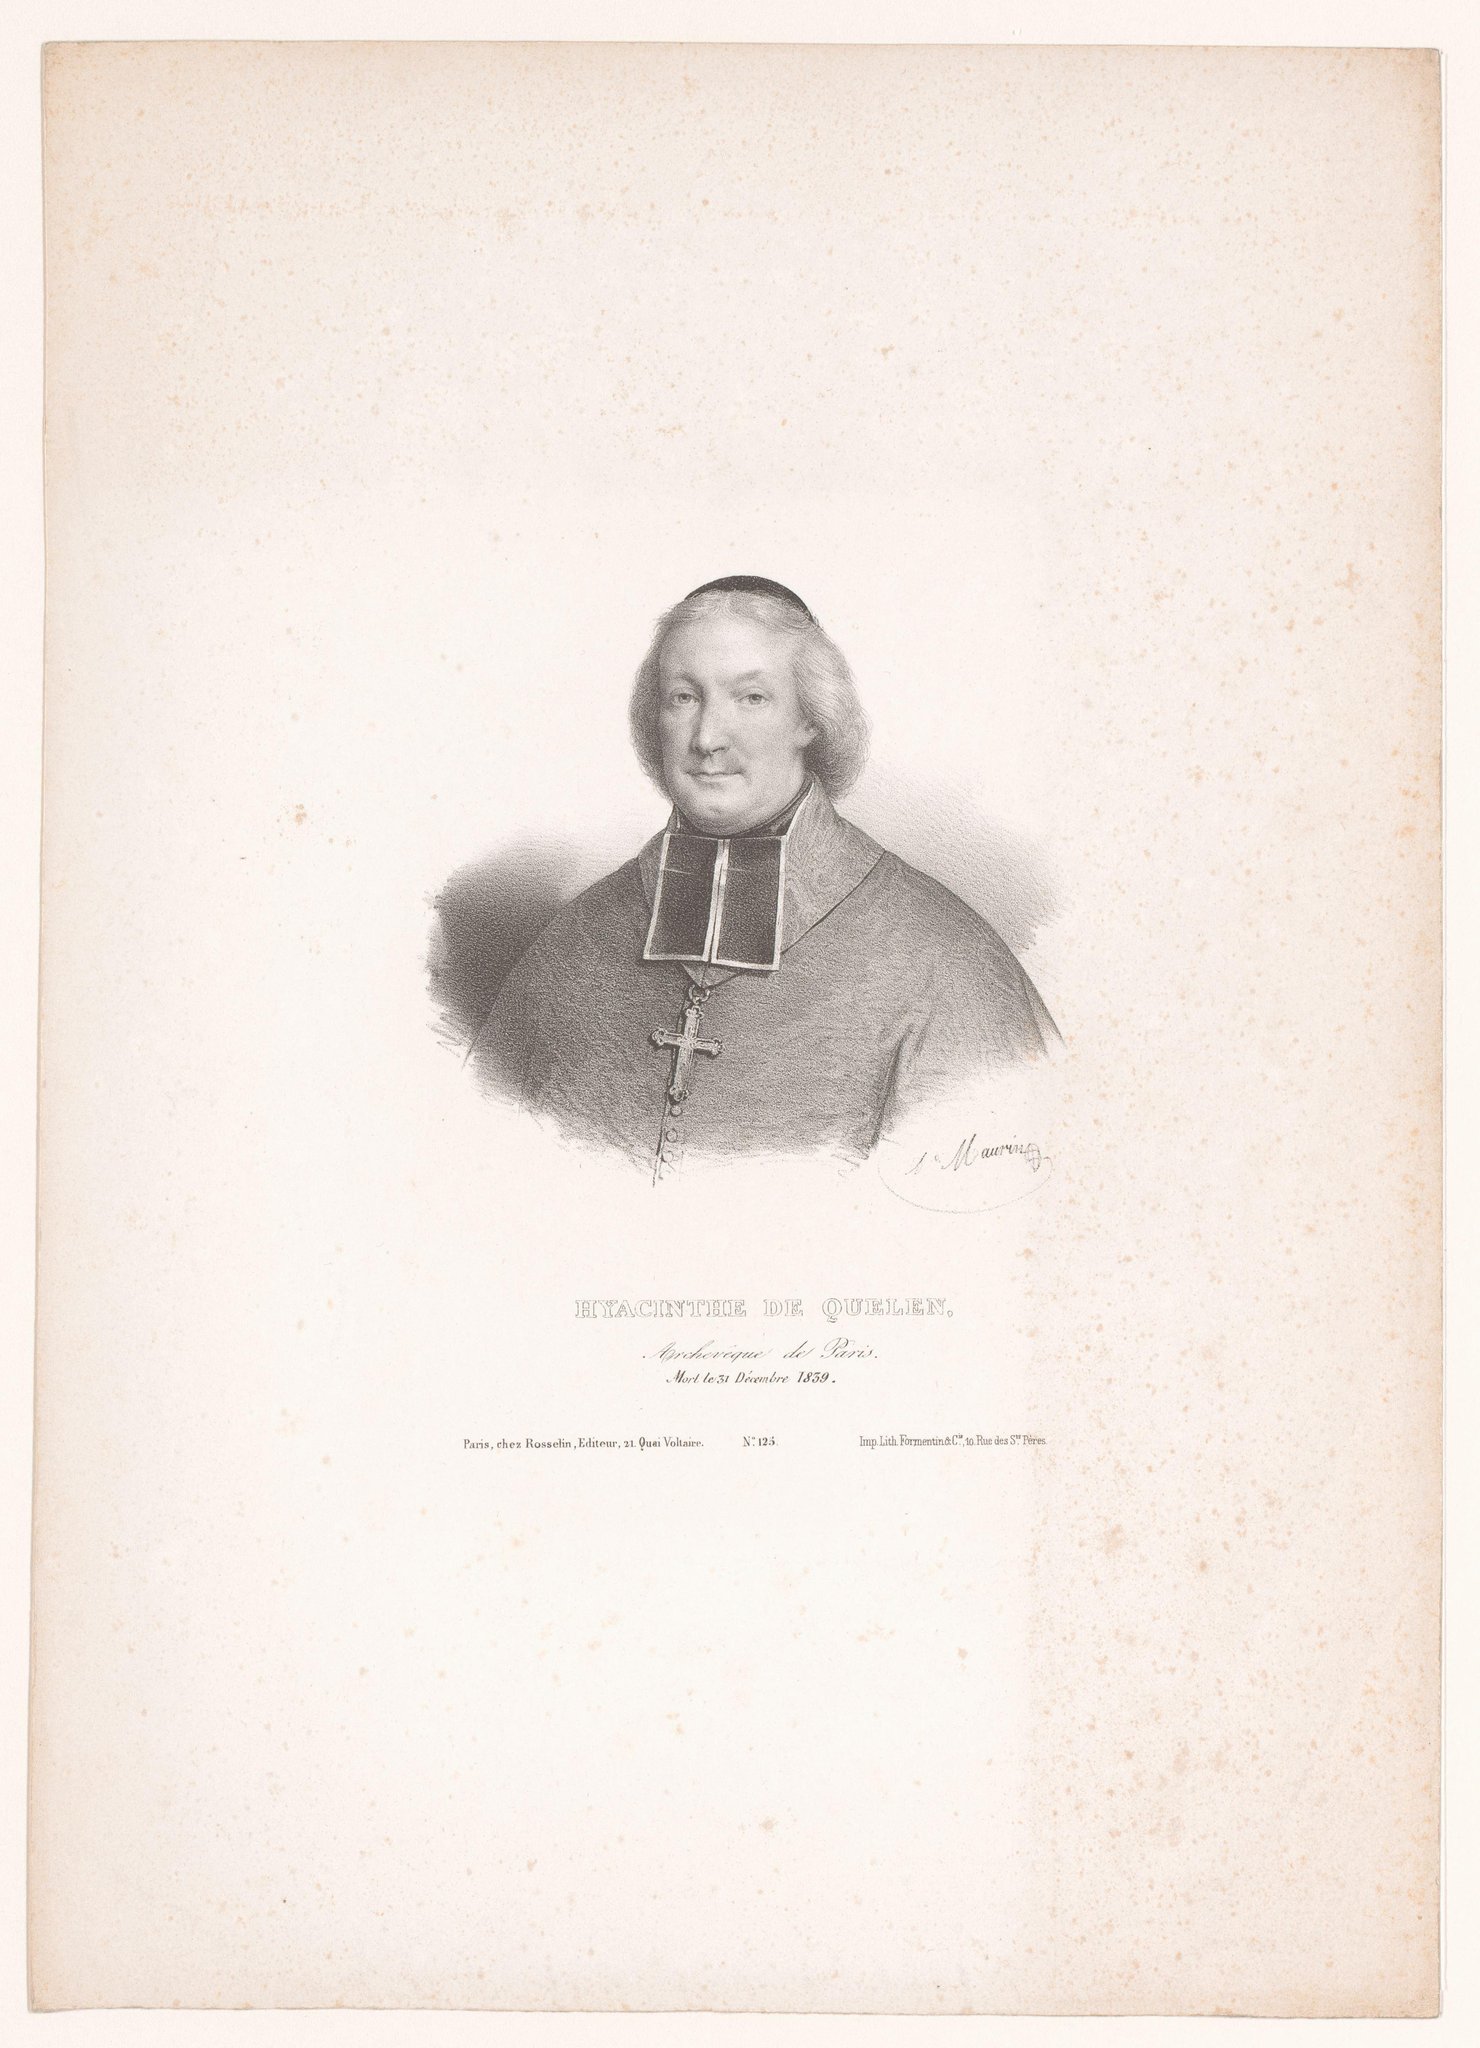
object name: print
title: Portret van Hyacinthe-Louis de Quélen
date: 1839-1856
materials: paper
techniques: lithograph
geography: paris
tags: archbishop, bishop, etc. (roman catholic), historical persons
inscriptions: collector's mark: Lugt 2228